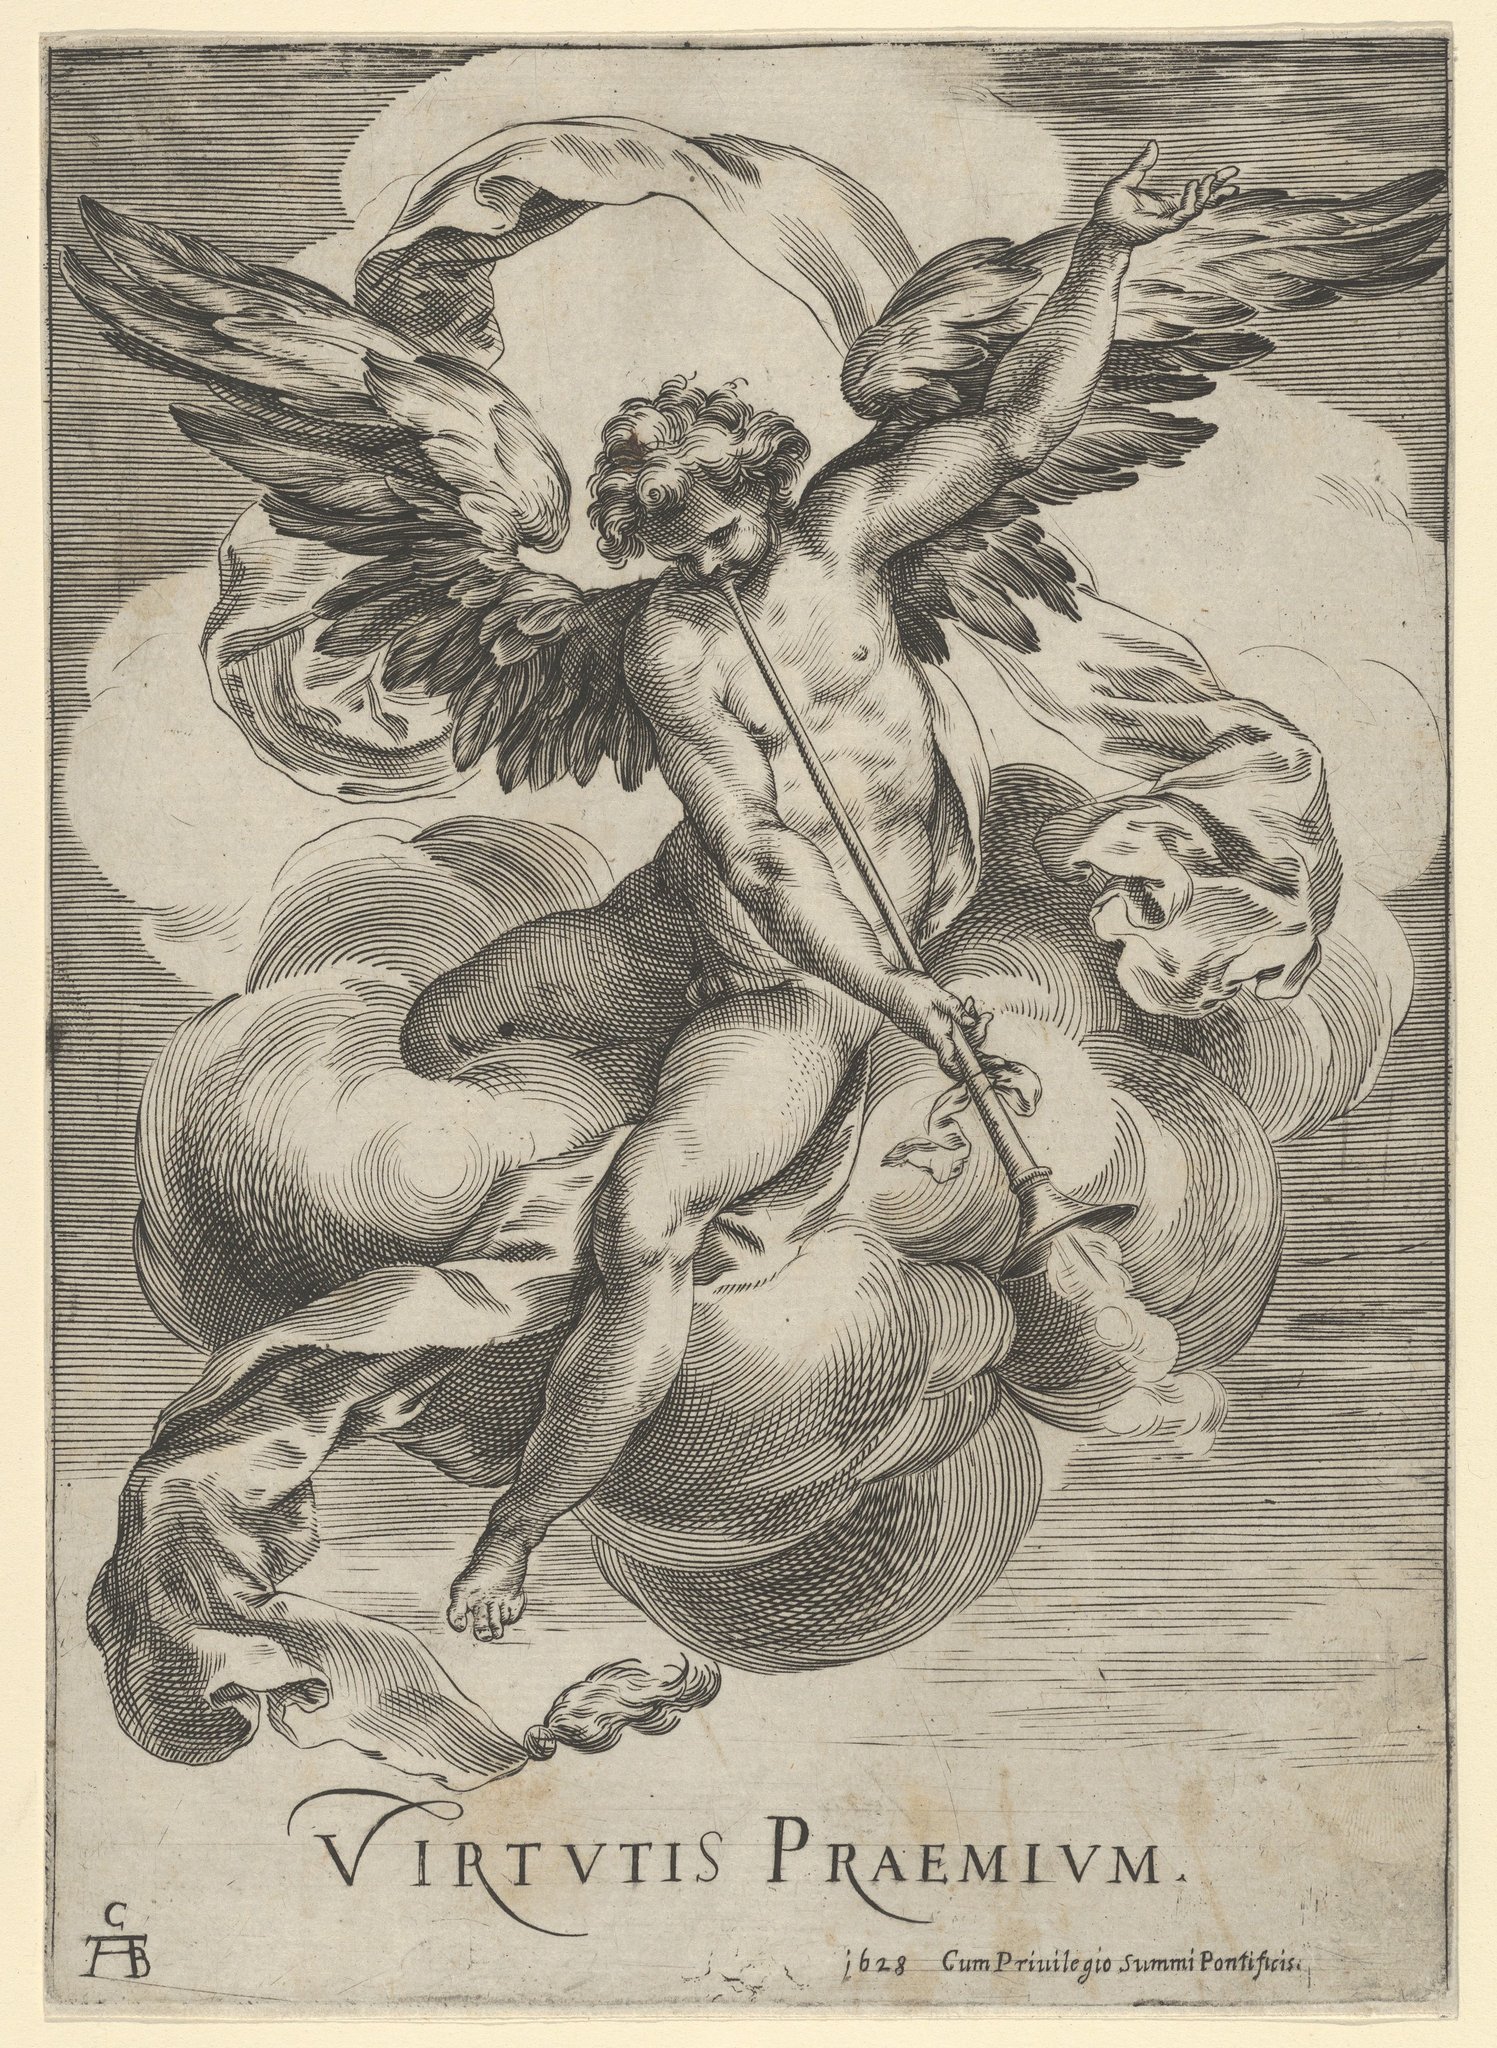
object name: print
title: Winged genius seated on a cloud, sounding a trumpet with his left hand extended upwards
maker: cherubino alberti (zaccaria mattia)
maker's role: artist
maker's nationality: italian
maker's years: 1553-1615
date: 1628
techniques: engraving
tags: male nudes,trumpets